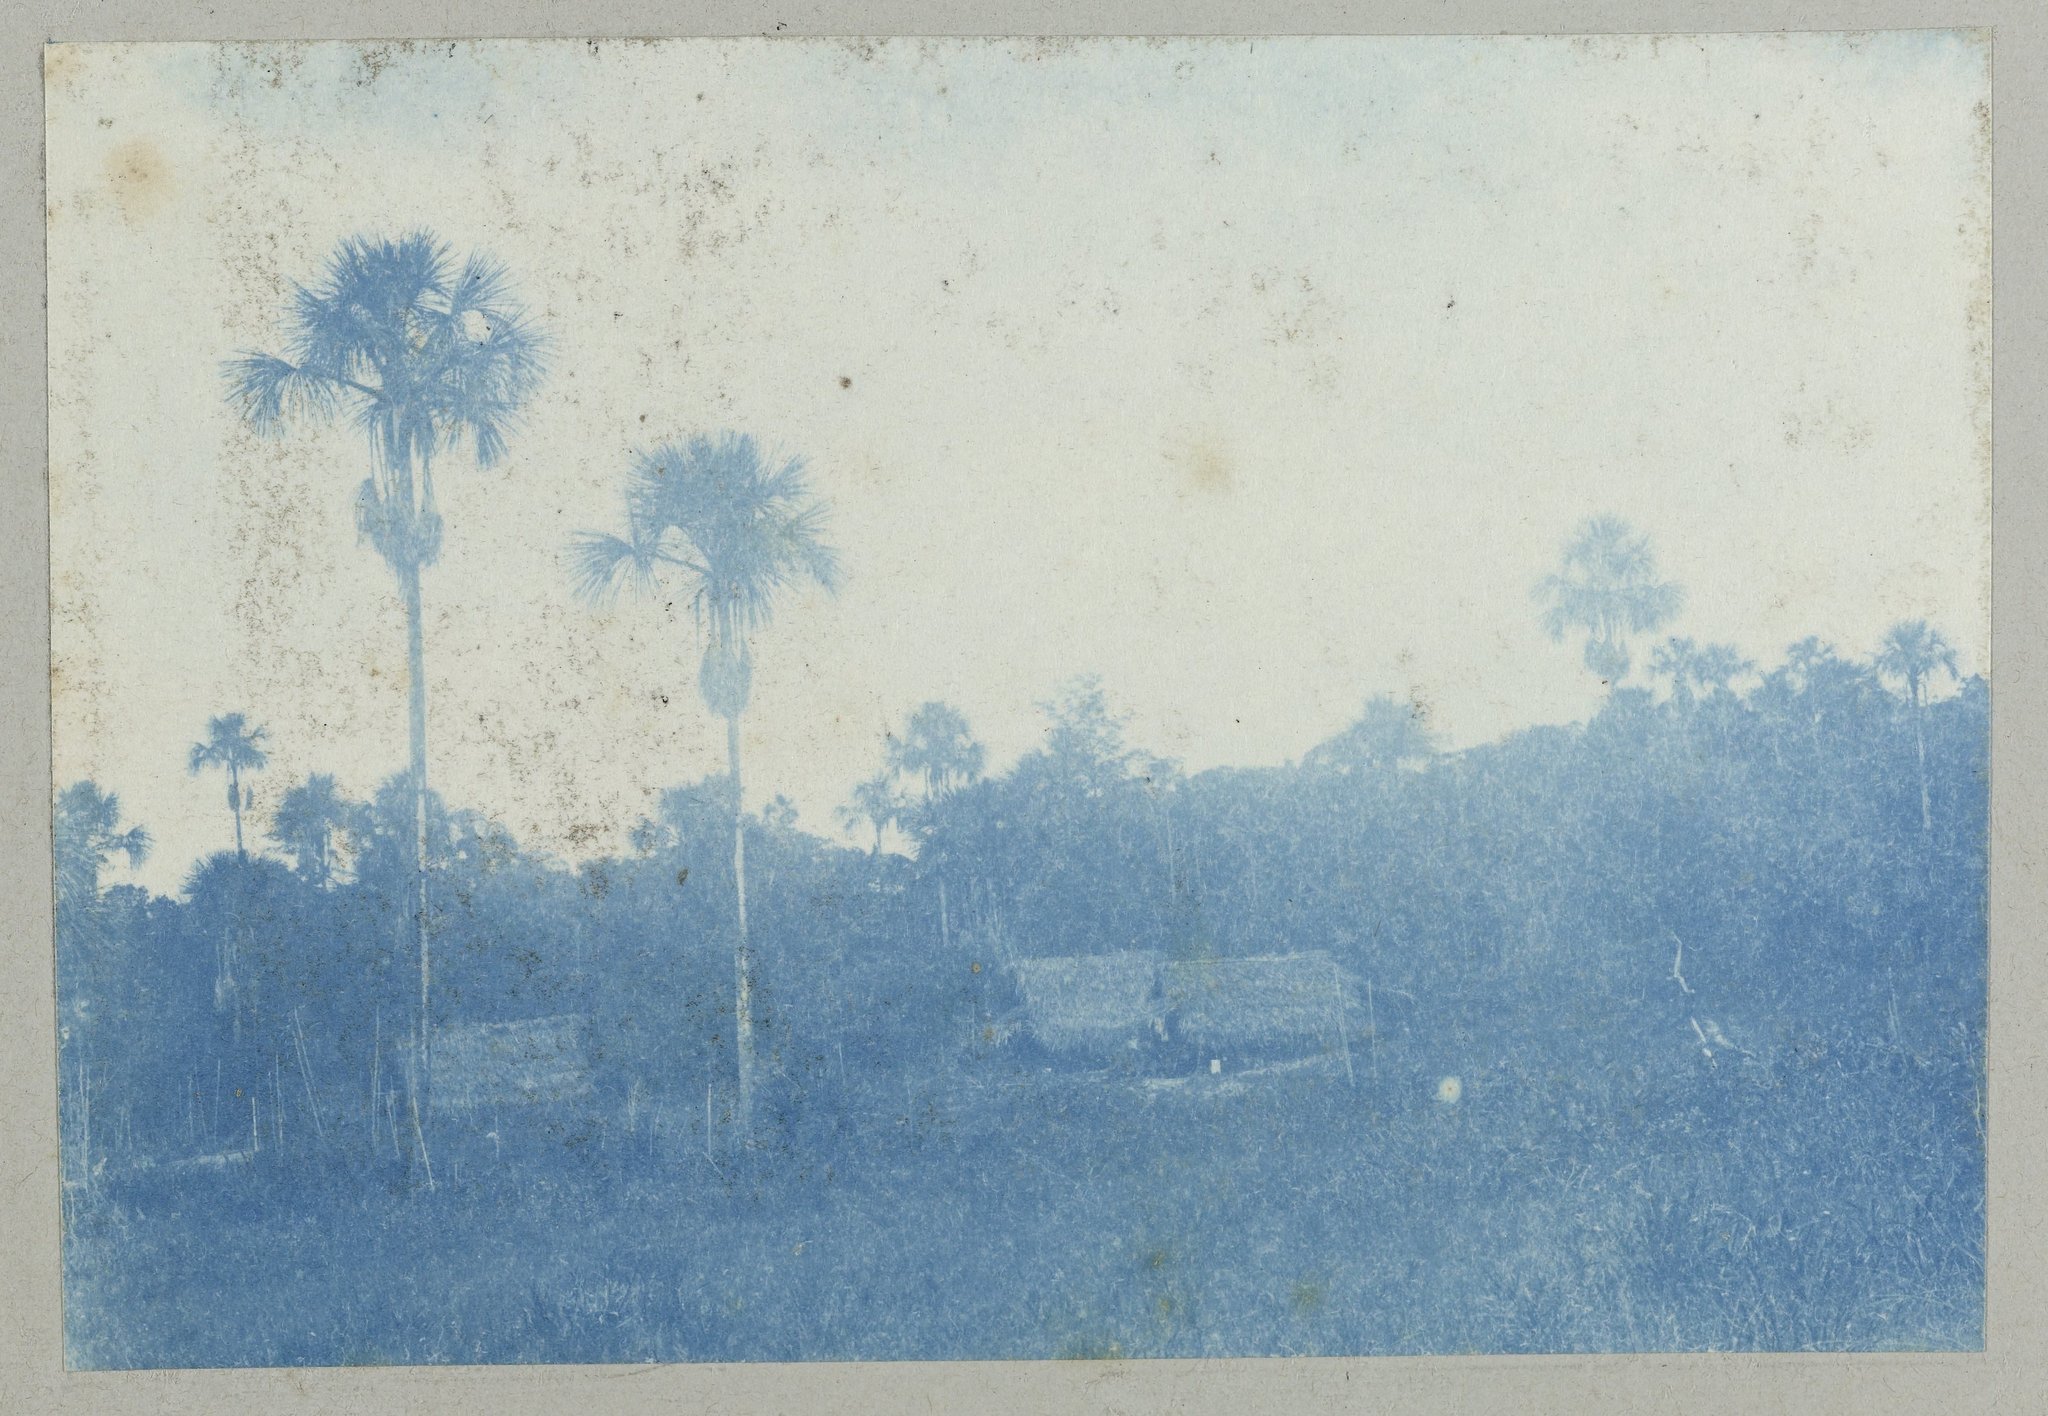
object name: photograph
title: Patrick-savanna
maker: hendrik doijer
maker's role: engineer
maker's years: 1863-1925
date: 1903-1910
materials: photographic support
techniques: cyanotype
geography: suriname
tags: suriname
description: Verschillende huizen aan de rand van het bos, volgens het onderschrift betreft het de Patrick-savanna. Onderdeel van het fotoalbum Souvenir de Voyage (deel 1), over het leven van de familie Doijer in en rond de plantage Ma Retraite in Suriname in de jaren 1903-1910.